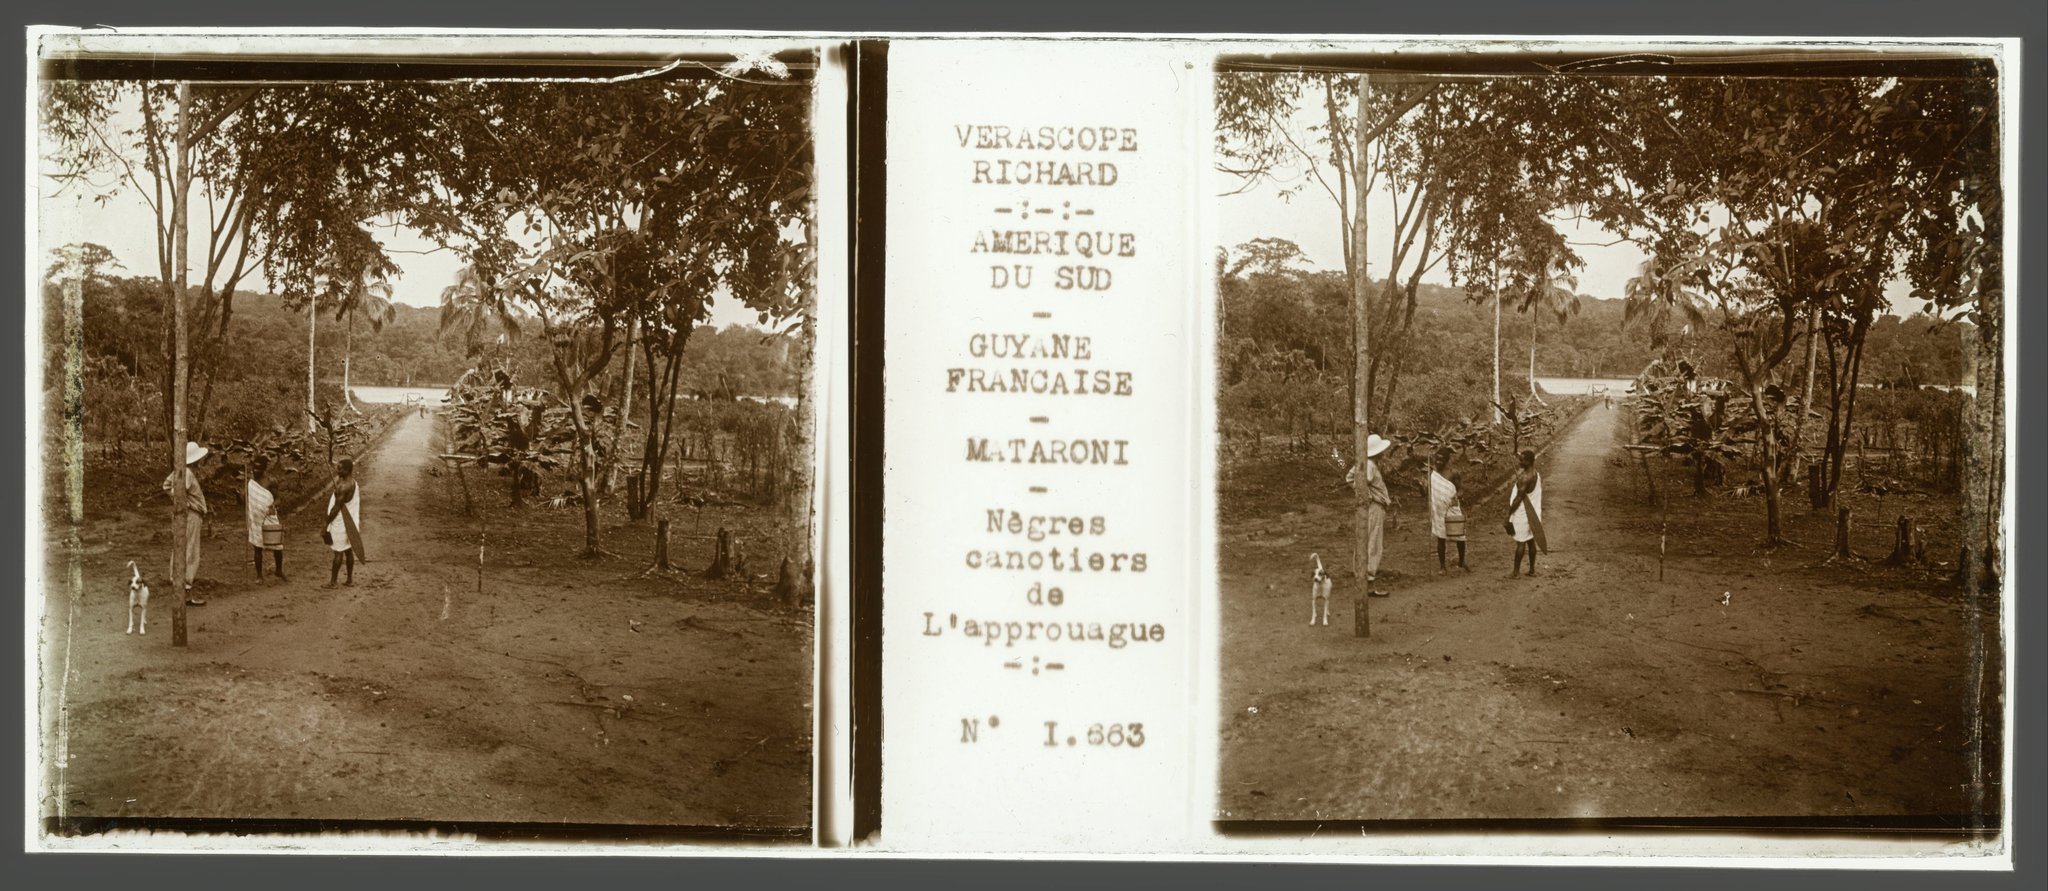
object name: stereoscopic photograph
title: Europeaan en twee lokale mannen bij de rivier de Approuague in Frans-Guyana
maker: Anonymous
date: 1893-1920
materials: glass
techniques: gelatin silver transparency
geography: french guiana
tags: indigenous peoples of south america, forest, wood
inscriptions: number: ‘No 1.663’